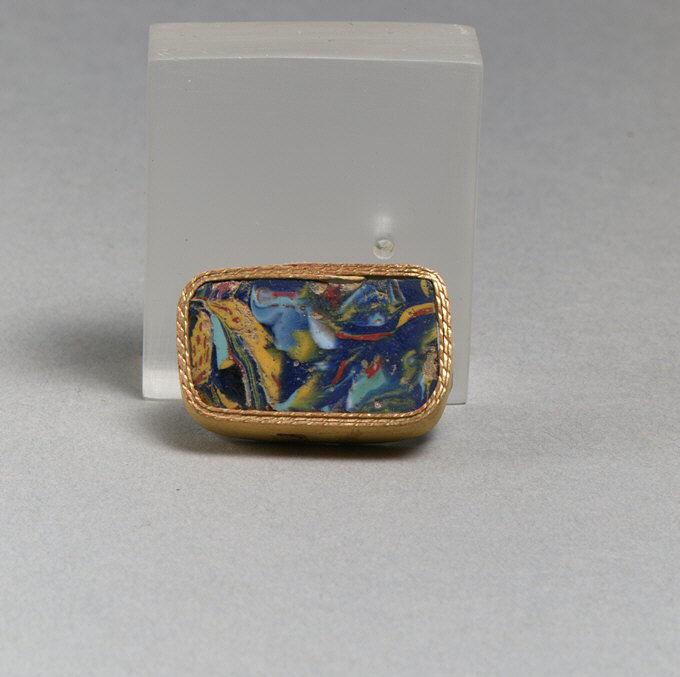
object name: fragment, mosaic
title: Glass mosaic fragment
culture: roman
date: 34 BCE-33 CE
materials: glass